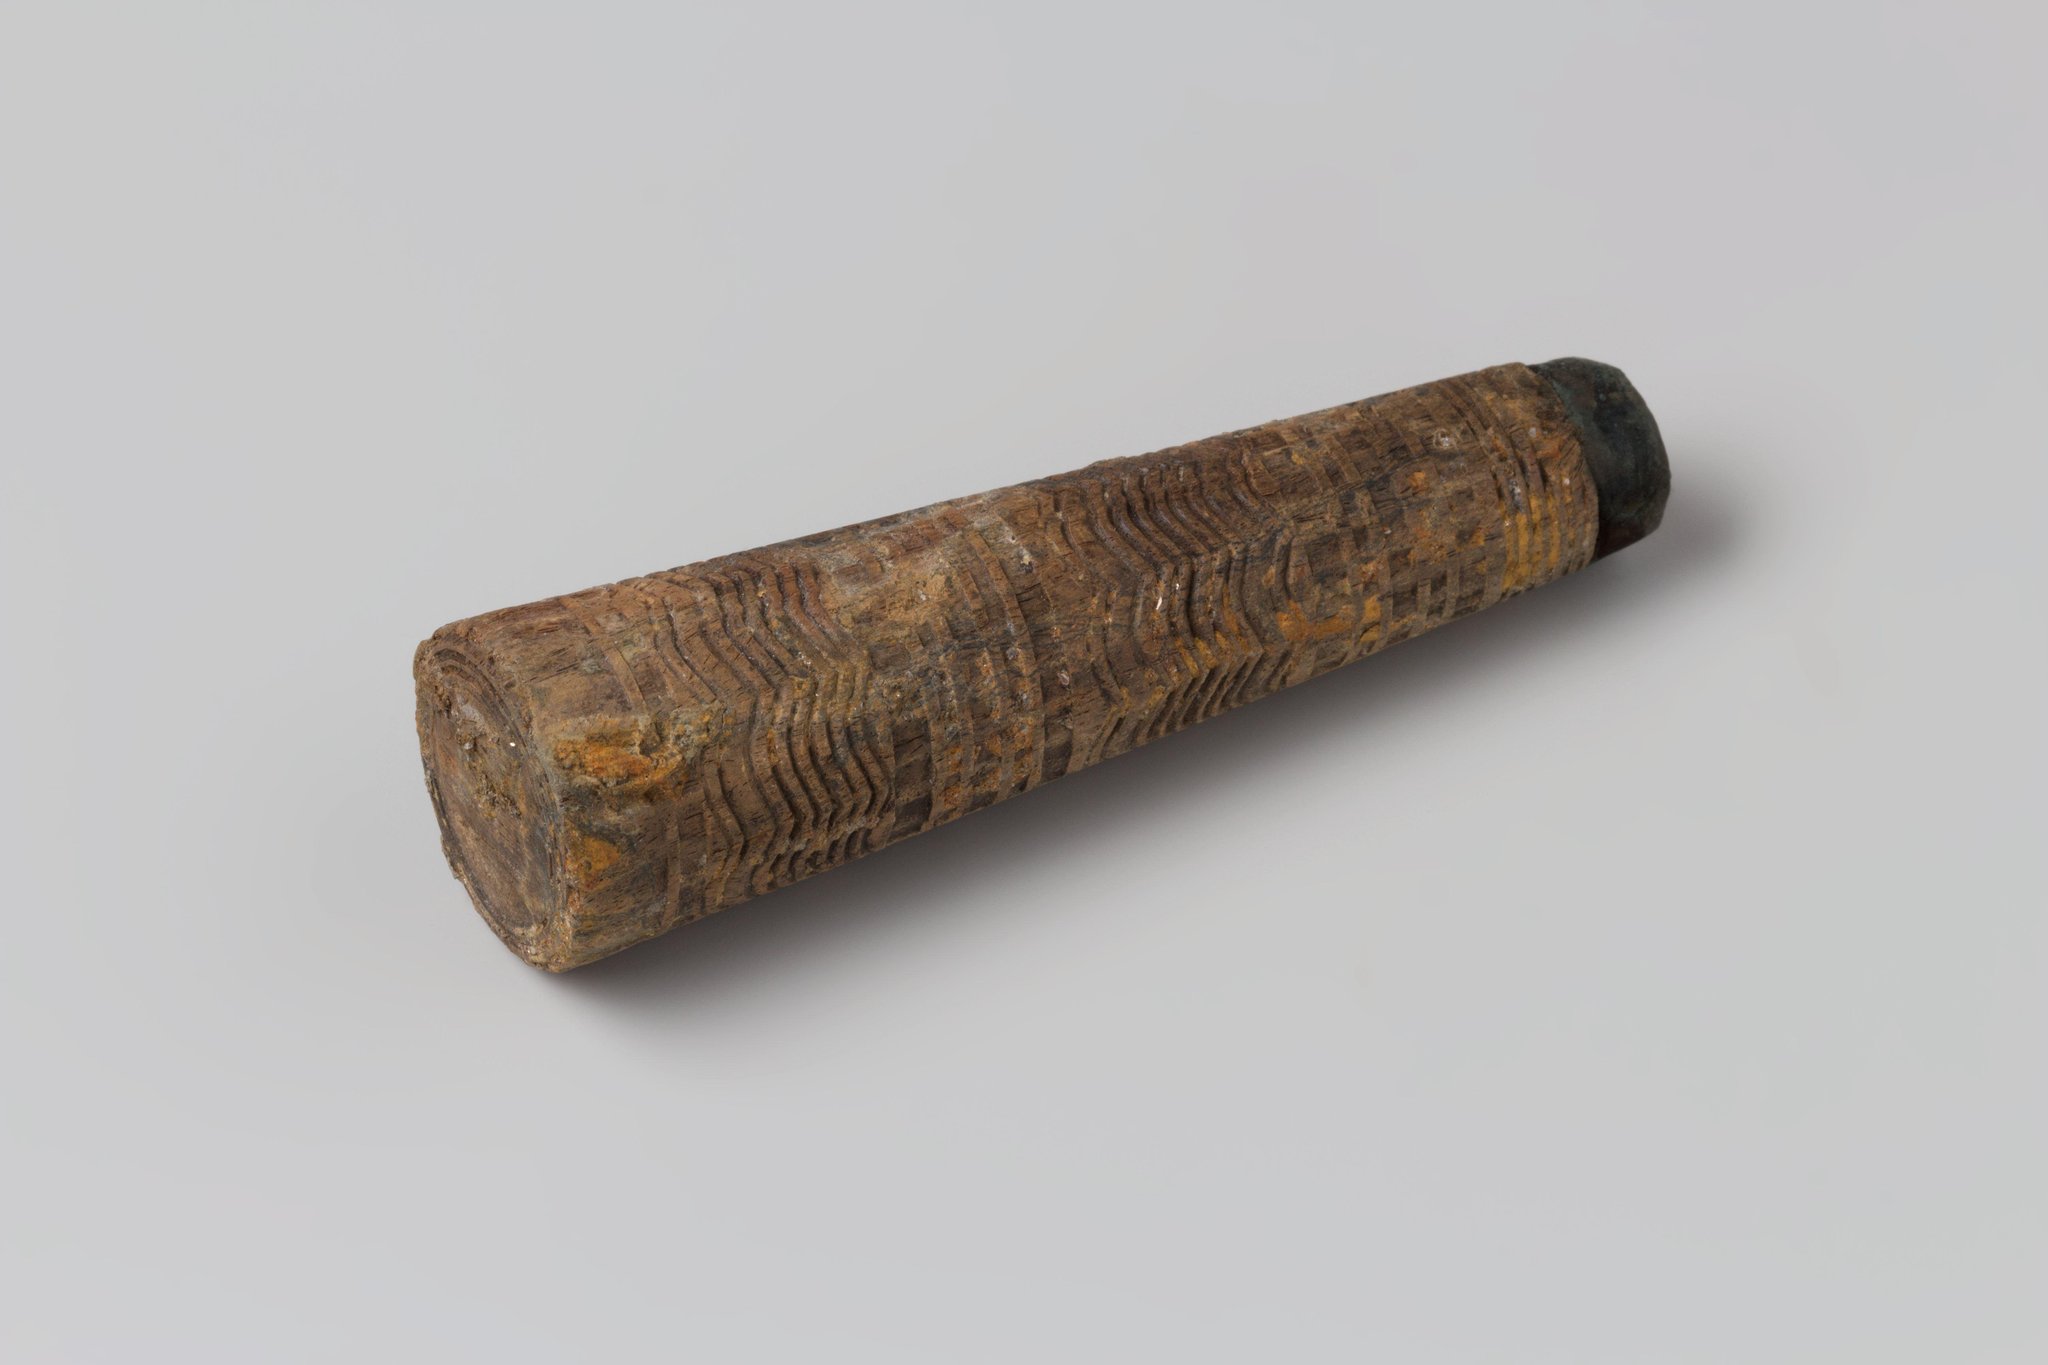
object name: knife handle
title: Messenheft uit het wrak van de Oost-Indiëvaarder Hollandia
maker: Anonymous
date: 1700-1743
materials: copper, wood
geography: netherlands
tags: verenigde oostindische compagnie, hollandia (schip), annet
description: Knife, handle, cylindrical: tapering; id. NG 1979-403H, ferrules, id. NG 1980-27H426.